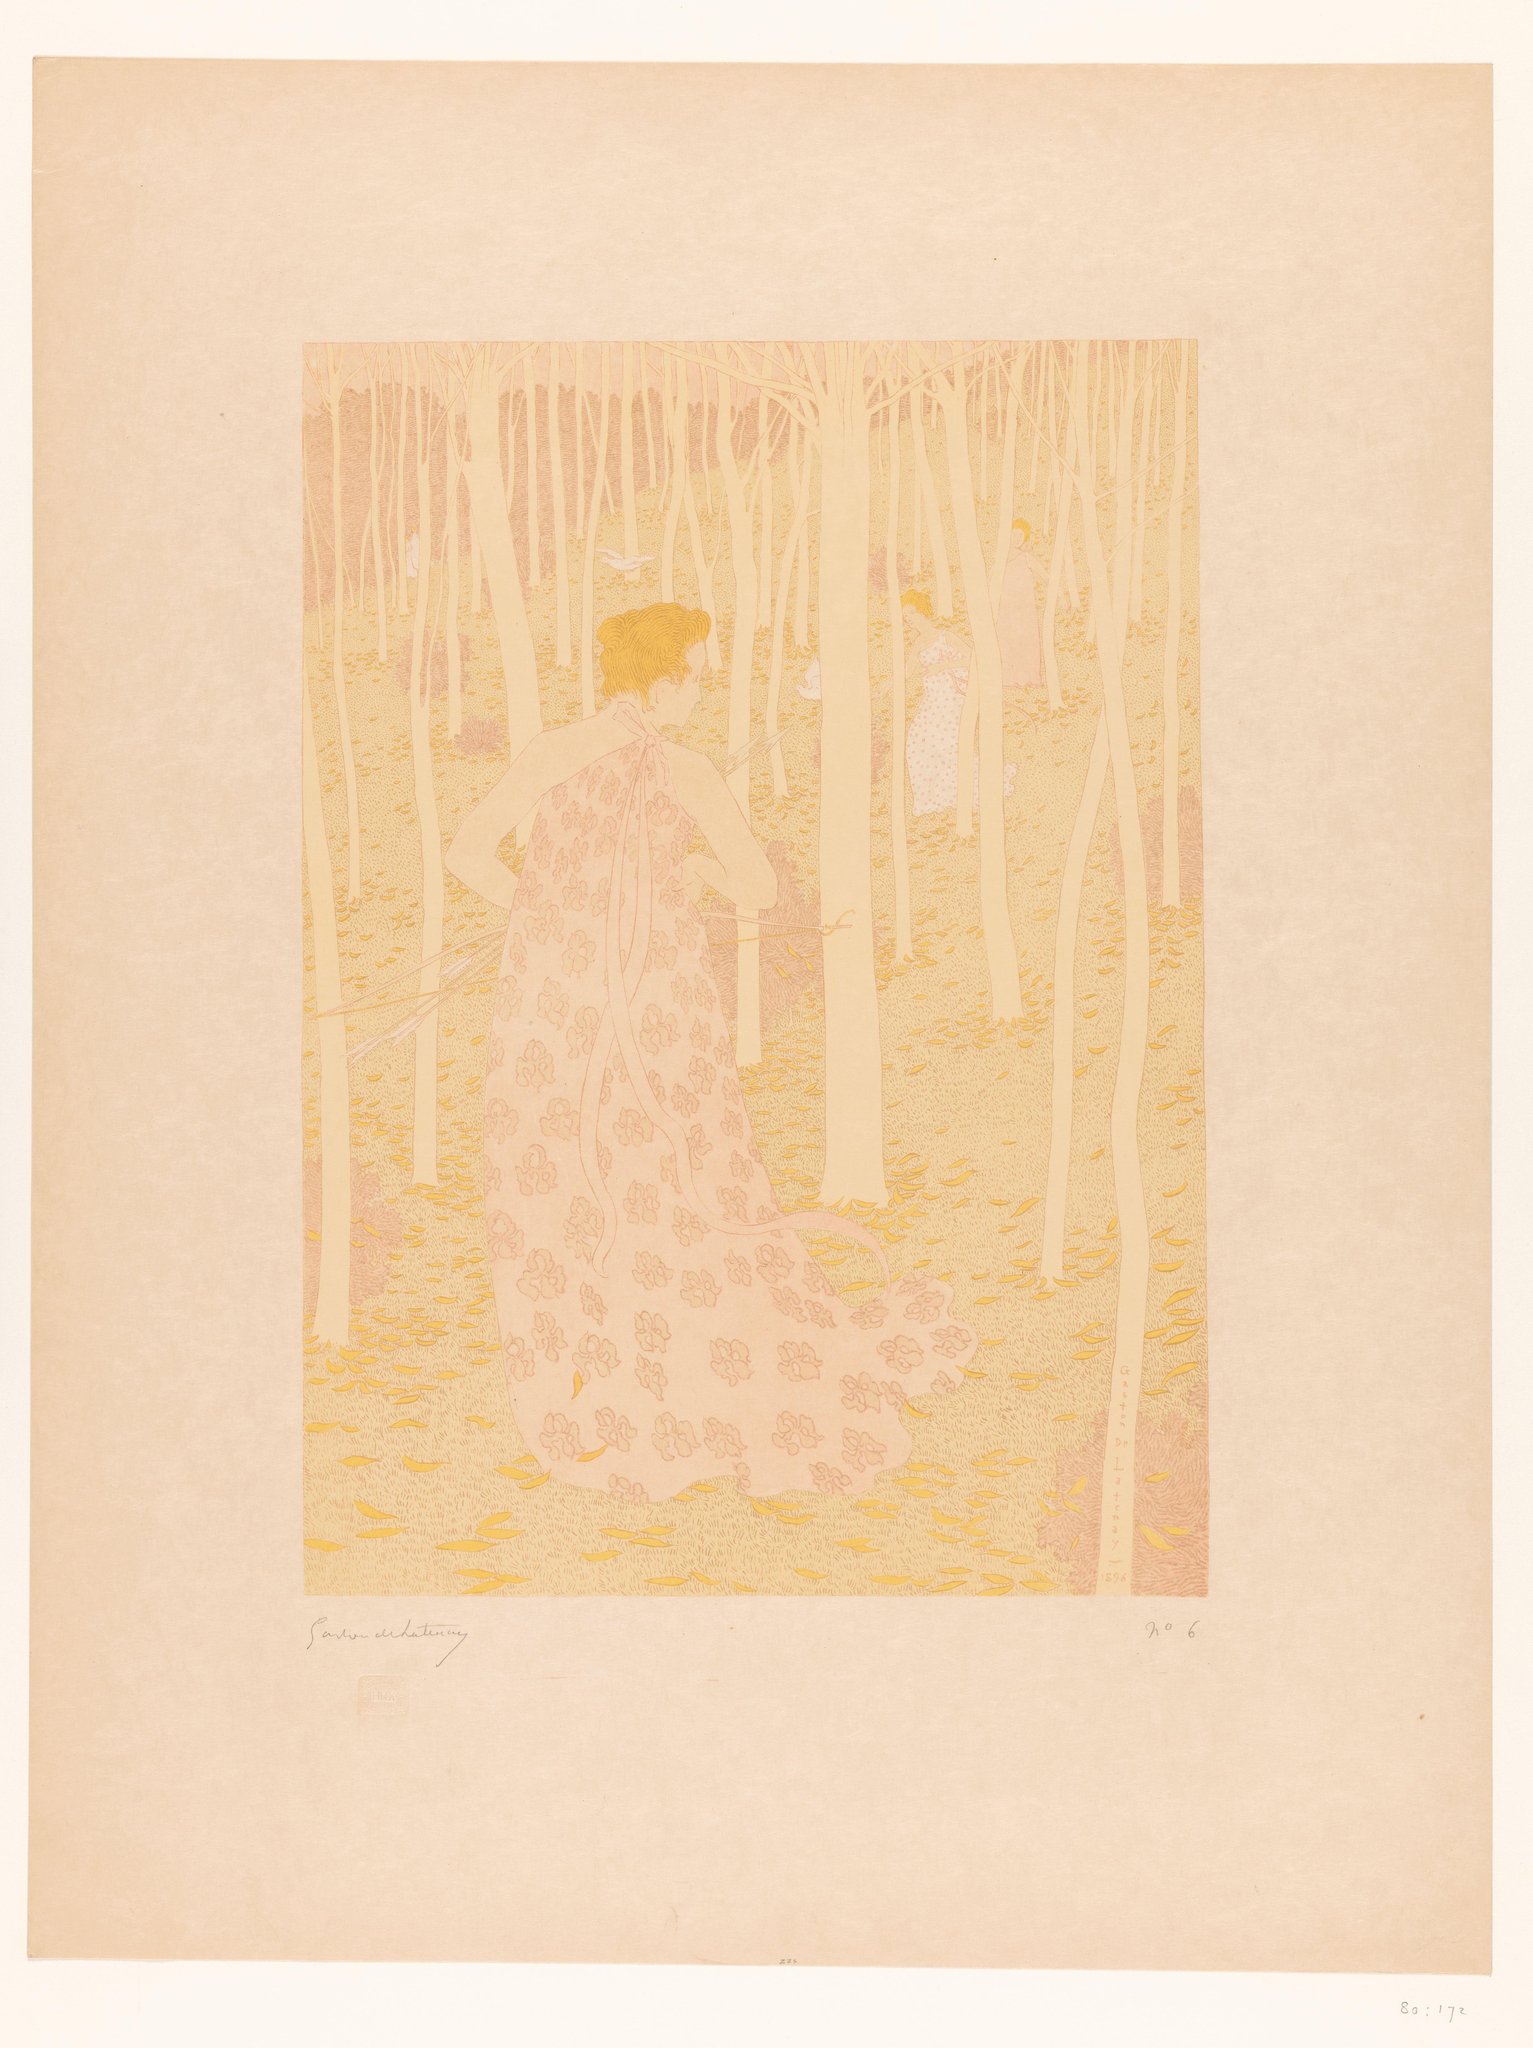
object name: print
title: Vrouwen op jacht in een bos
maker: gaston de latenay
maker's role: print maker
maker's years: 1859-1943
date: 1896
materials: paper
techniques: lithograph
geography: france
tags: forest, wood, hunters resting during the hunt, hunter - cc - female hunter, huntress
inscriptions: collector's mark: Lugt 2228, collector's mark: Lugt 2760, check stamp: Lugt 438, check stamp: Lugt 2254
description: Prent wordt vermeld in: ‘Keuze uit de aanwinsten’, Bulletin van het Rijksmuseum 30 (1982), nr. 2, p. 87-102.